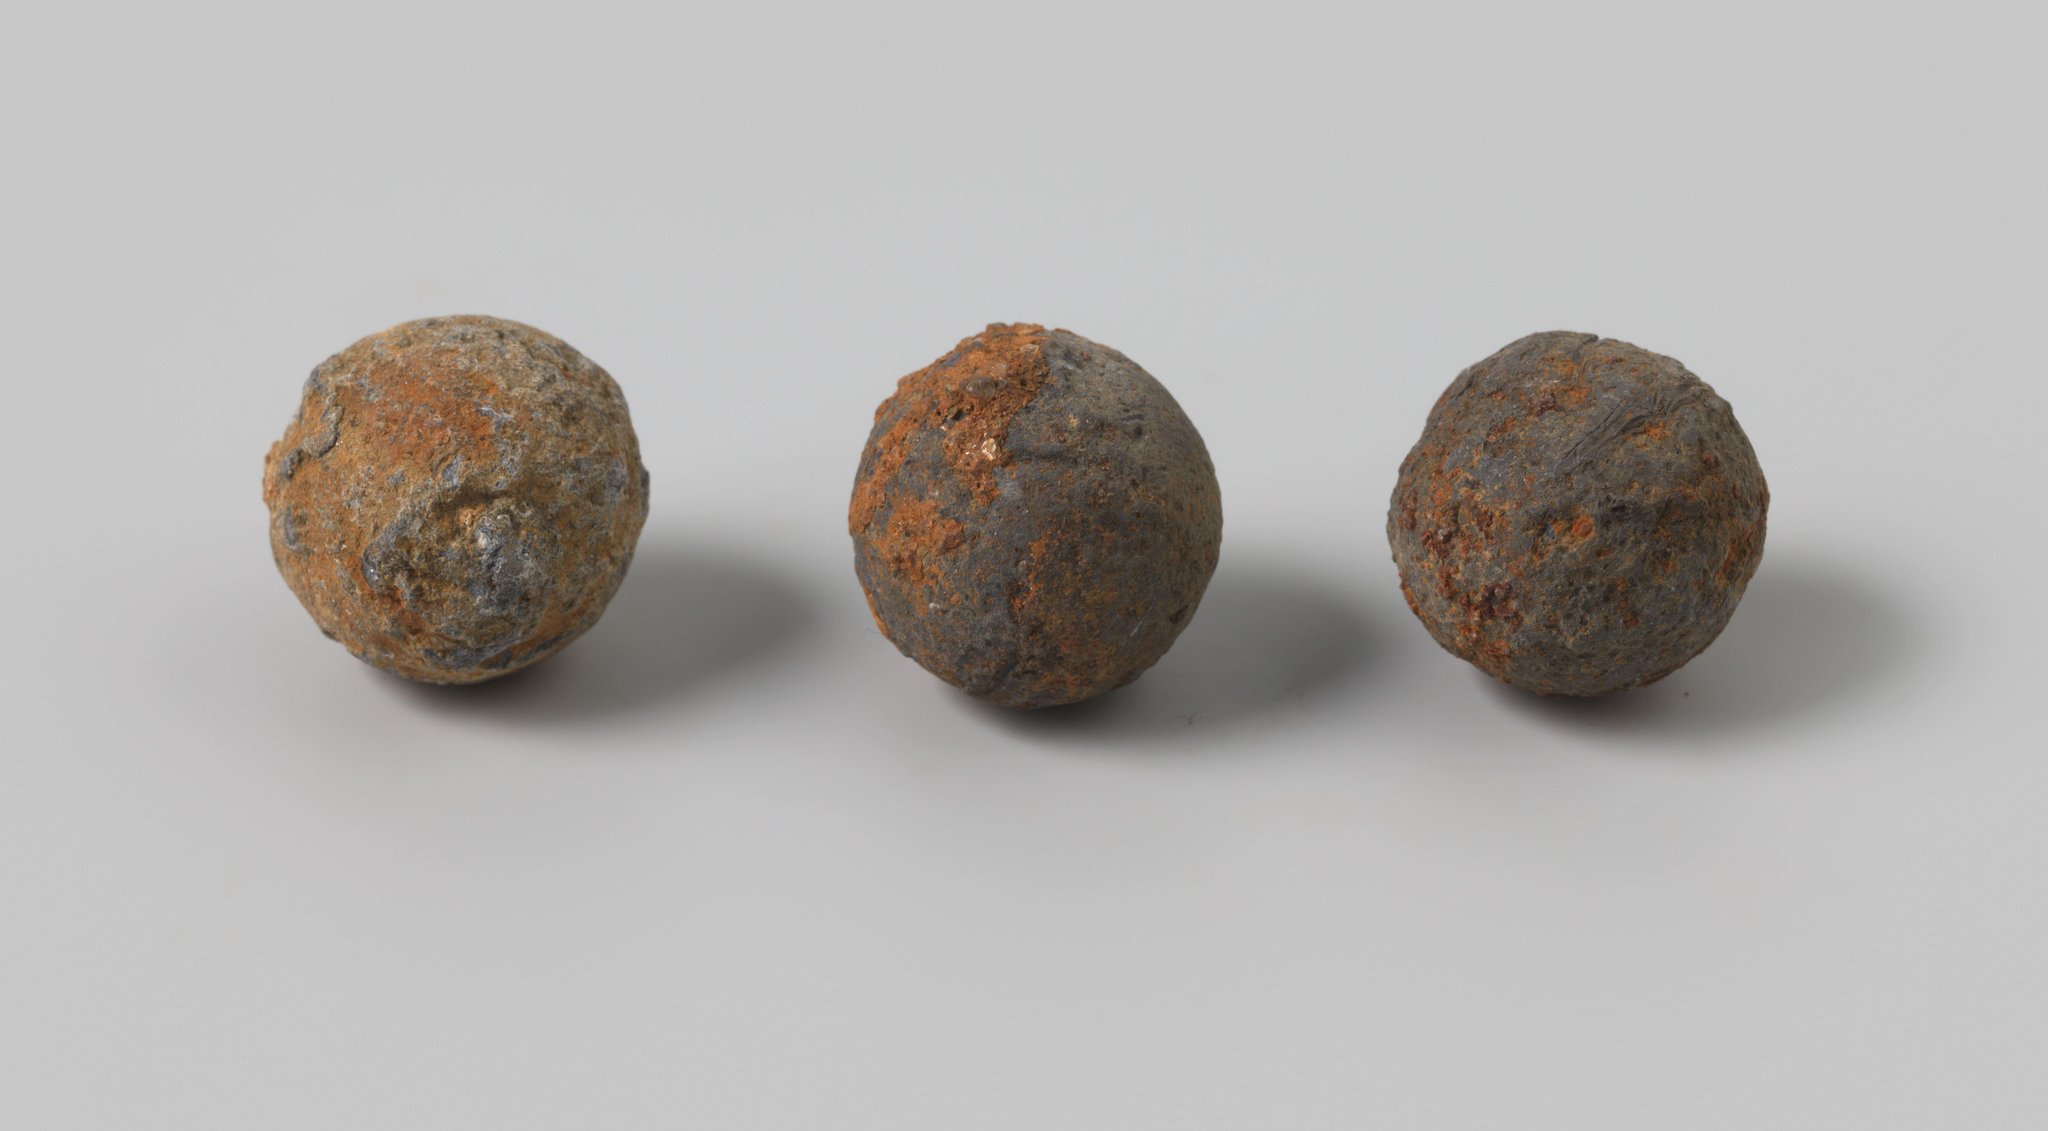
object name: musketkogel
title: Musketkogels uit het wrak van de Oost-Indiëvaarder Hollandia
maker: Anonymous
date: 1700-1743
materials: lead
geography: netherlands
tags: verenigde oostindische compagnie, hollandia (schip), annet